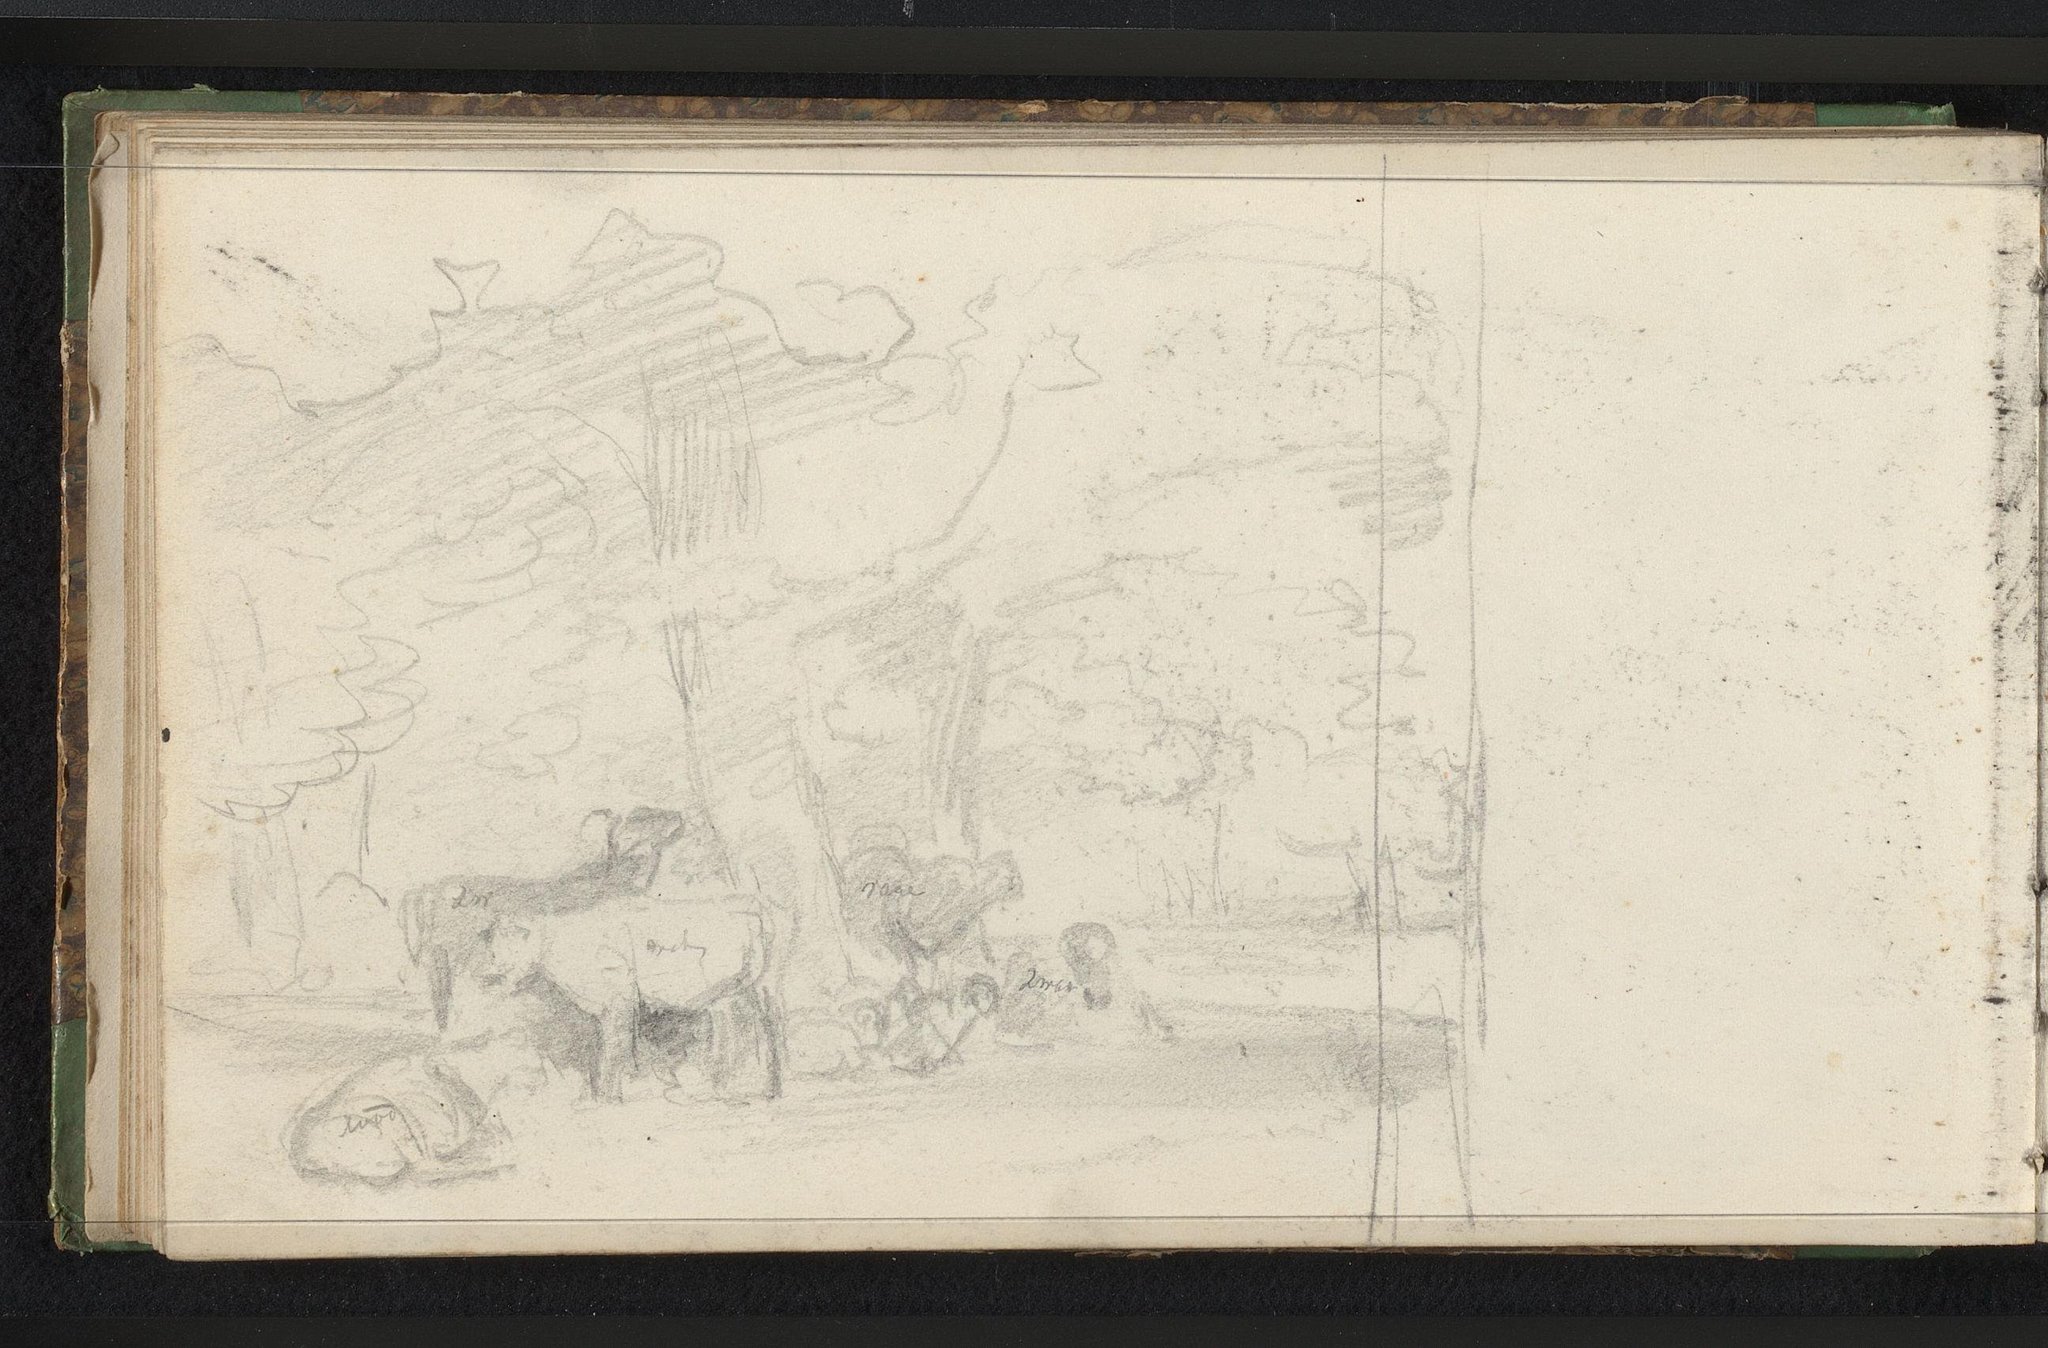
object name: sketchbook leaf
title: Runderen in een weiland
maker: jan bedijs tom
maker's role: draughtsman, painter, print maker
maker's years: 1813-1894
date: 1828-1894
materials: paper, pencil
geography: the hague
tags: trees, landscapes, meadow, pasture, artist (in general) making preliminary designs, sketching, bovine cattle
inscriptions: inscription: ‘Bomen / dubbel z[...]’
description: Pagina 50 verso uit een schetsboek met 50 bladen.